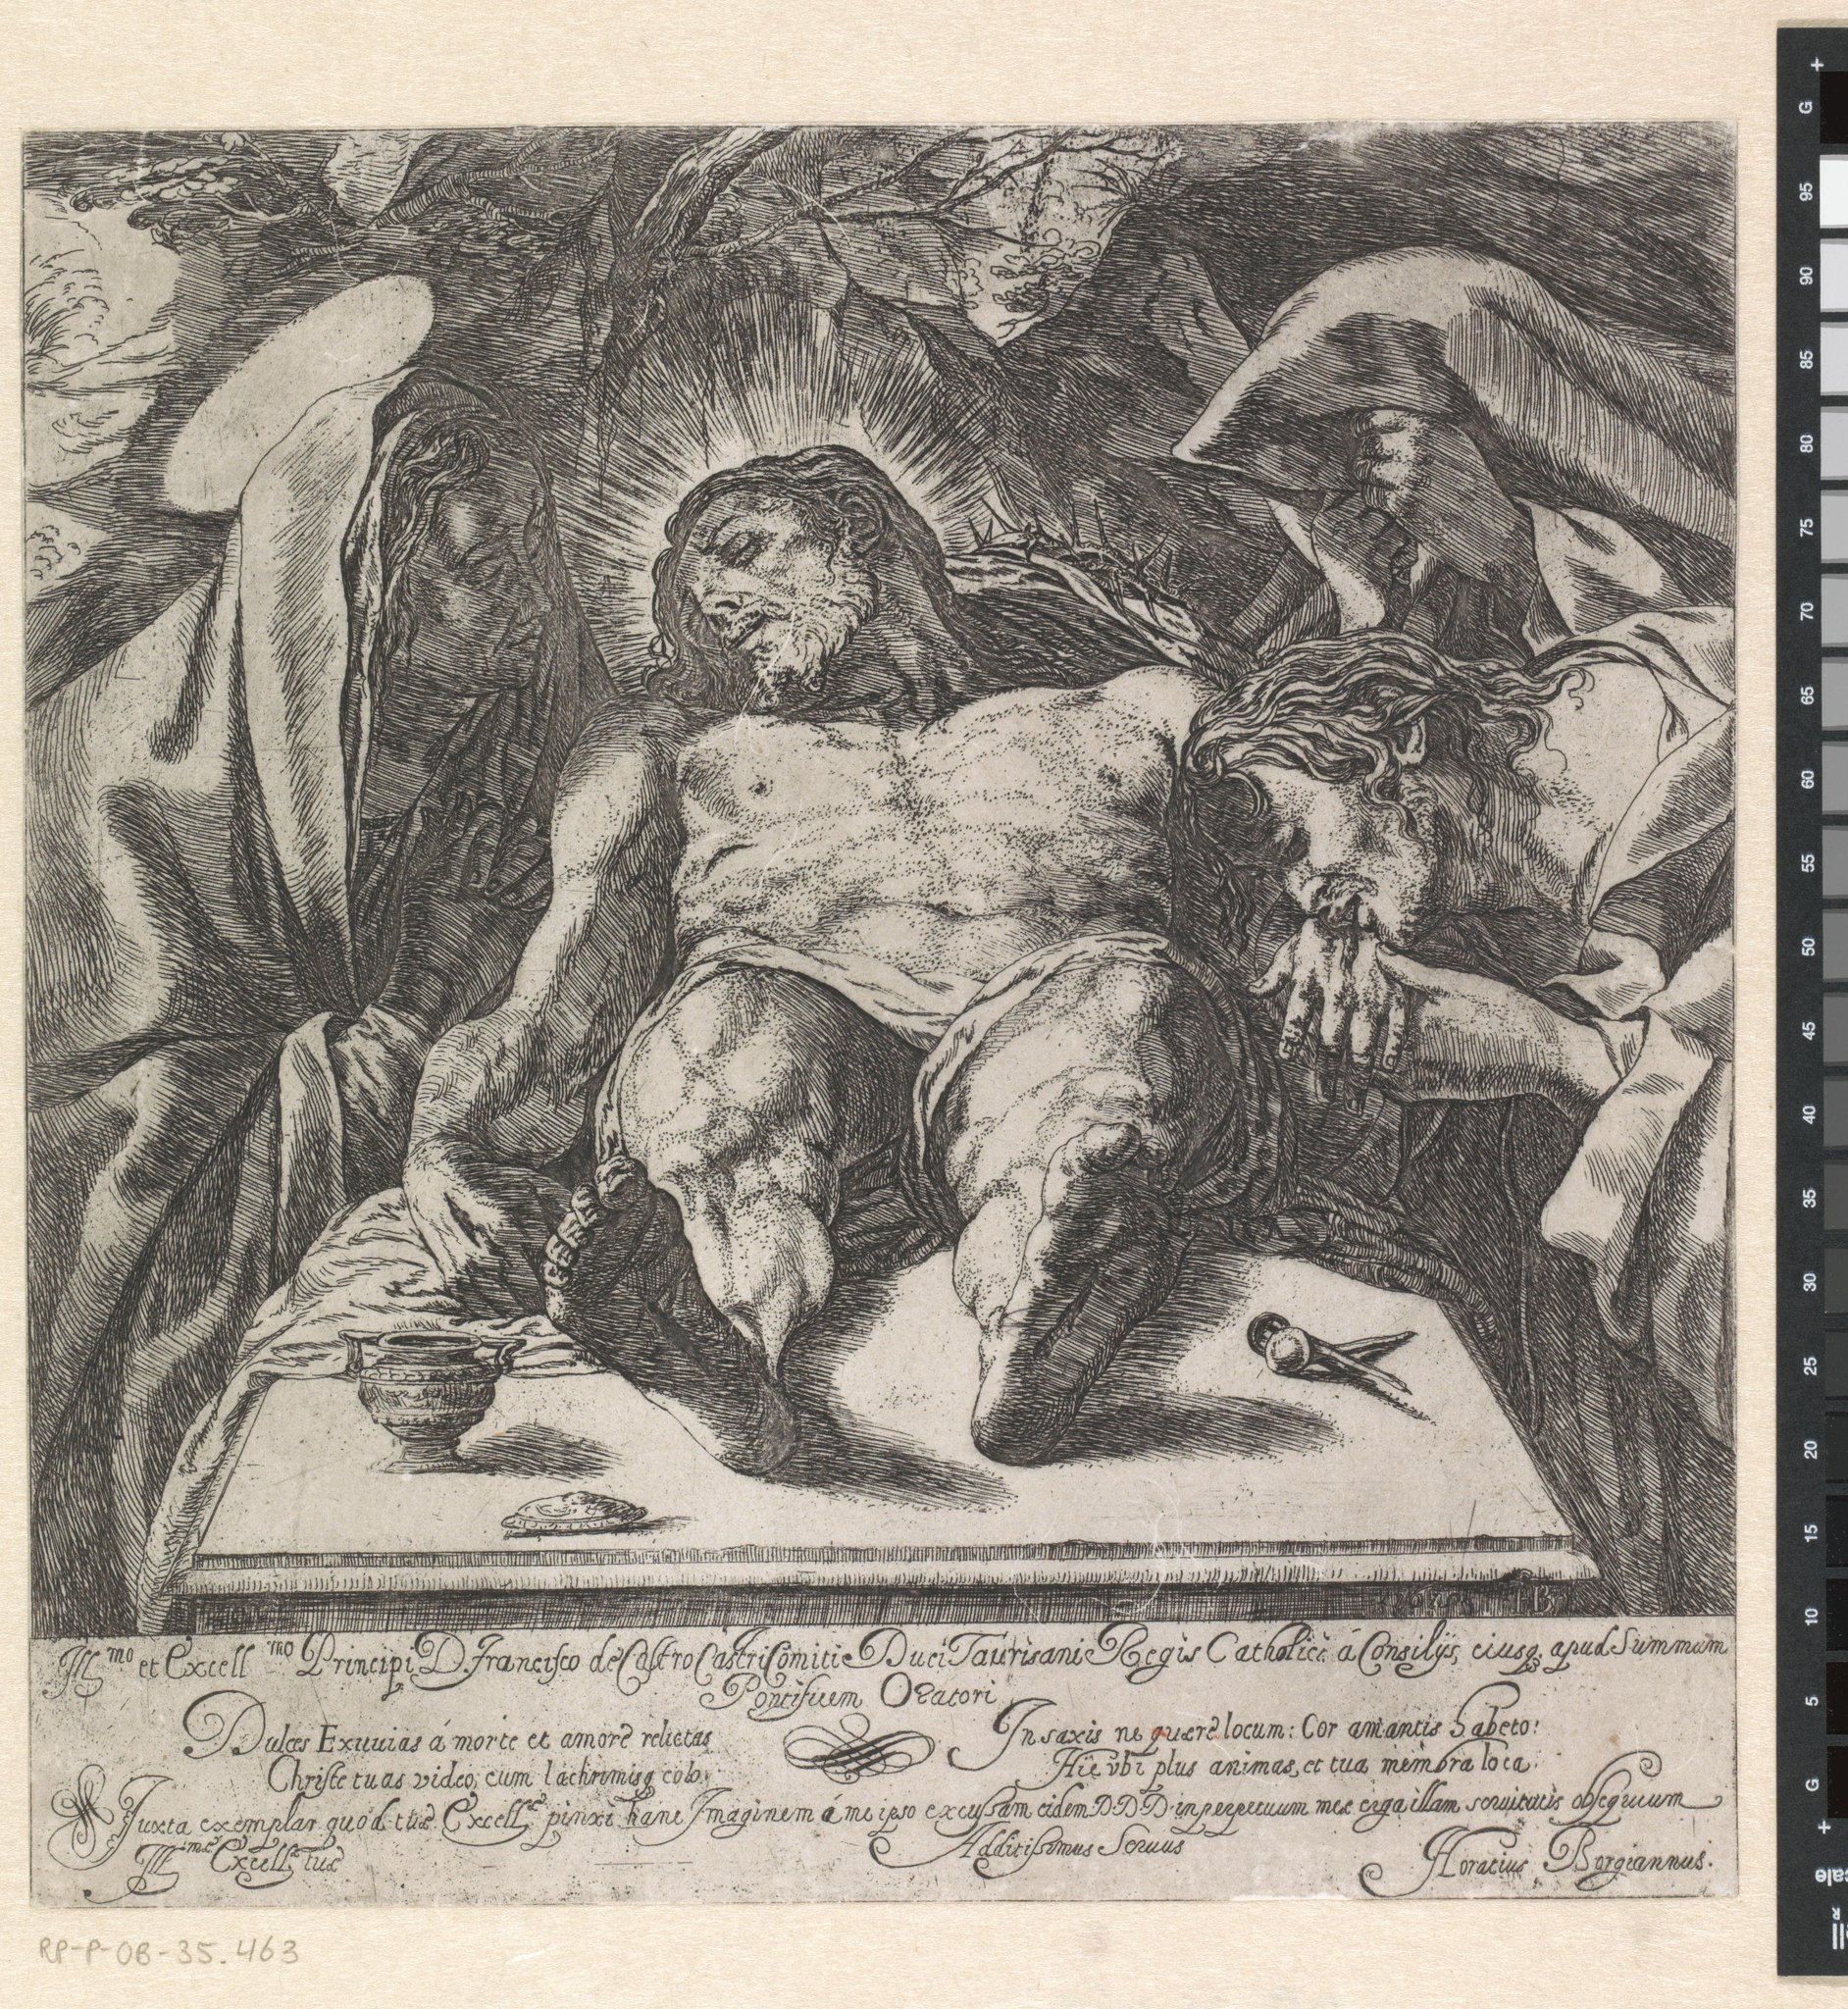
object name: print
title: Bewening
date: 1615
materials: paper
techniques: etching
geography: italy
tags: lamentation over the dead christ by his relatives and friends (christ usually without crown of thorns)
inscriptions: collector's mark: Lugt 240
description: Het lichaam van Christus wordt beweend door twee Maria's en Johannes de Evangelist. Tekst in ondermarge.